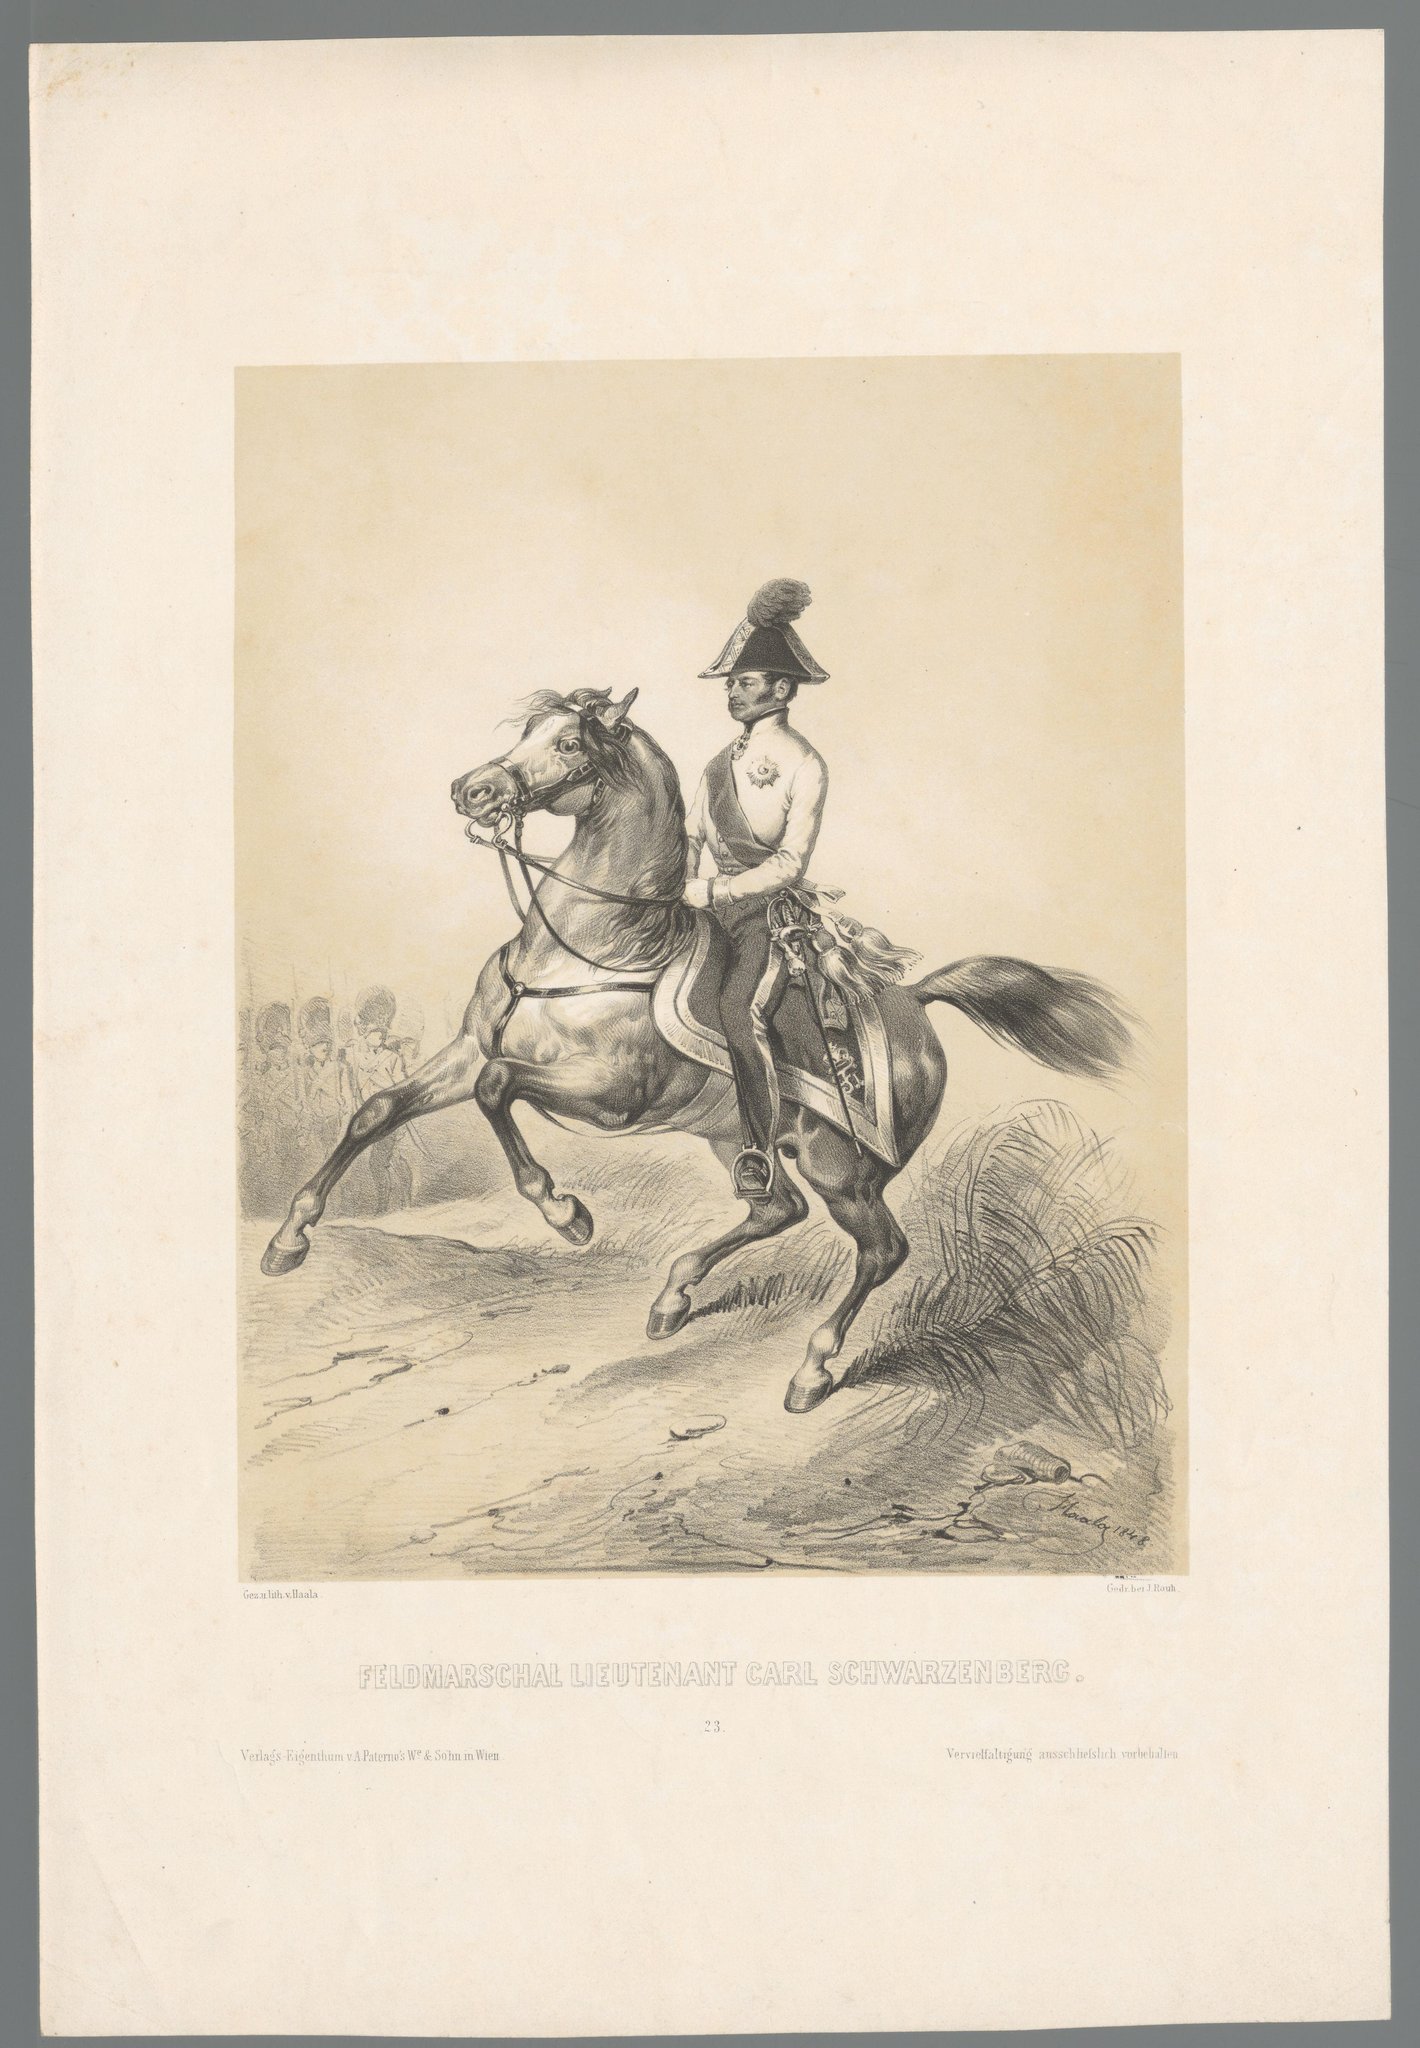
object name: print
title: Portret van Carl Philipp von Schwarzenberg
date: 1848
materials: paper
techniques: tone lithography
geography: vienna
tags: vienna, riding a horse, ass, or mule; rider, horseman, adult man, historical persons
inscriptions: collector's mark: Lugt 2228